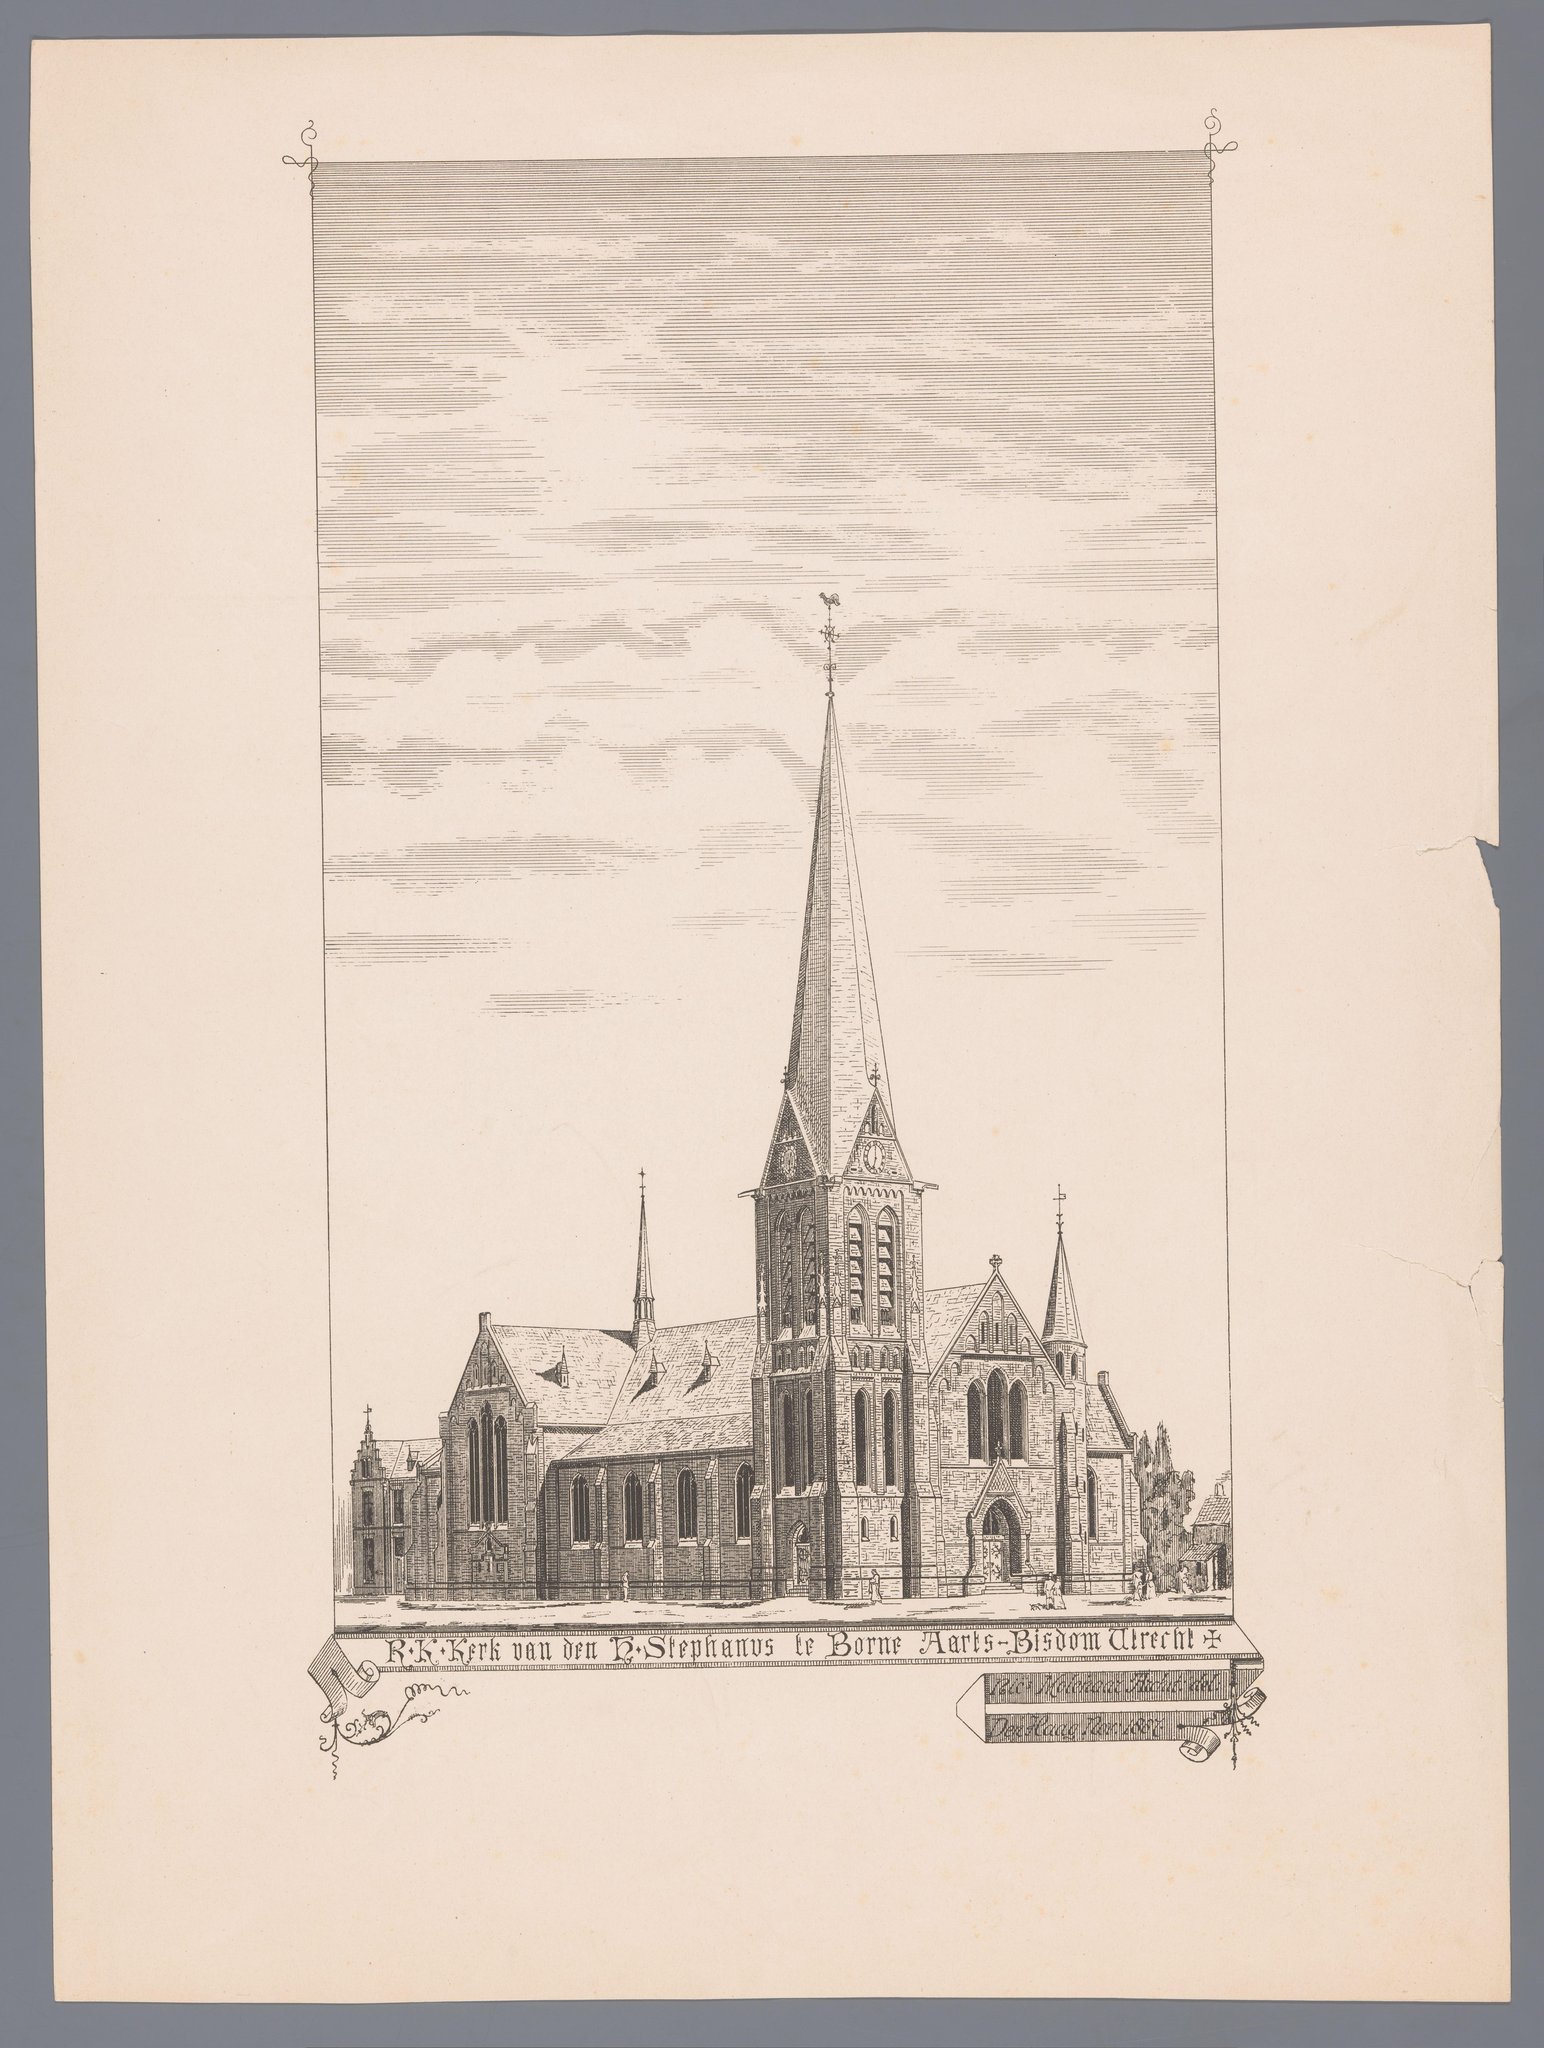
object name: reproduction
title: Reproductie van een ontwerp met een gezicht op de Sint-Stephanuskerk te Borne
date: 1811-1887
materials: paper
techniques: photolithography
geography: the hague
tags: church (exterior), architectural design or model